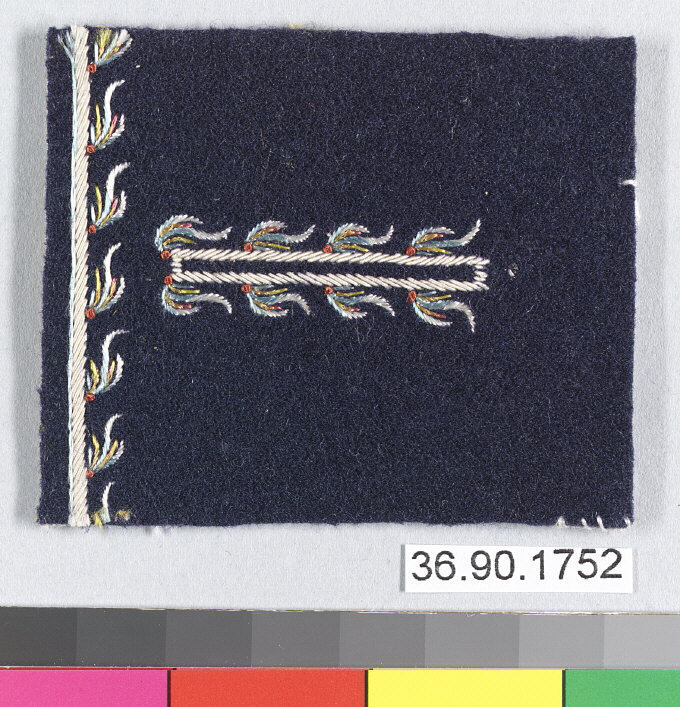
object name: sample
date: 1801-1833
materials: felt, silk